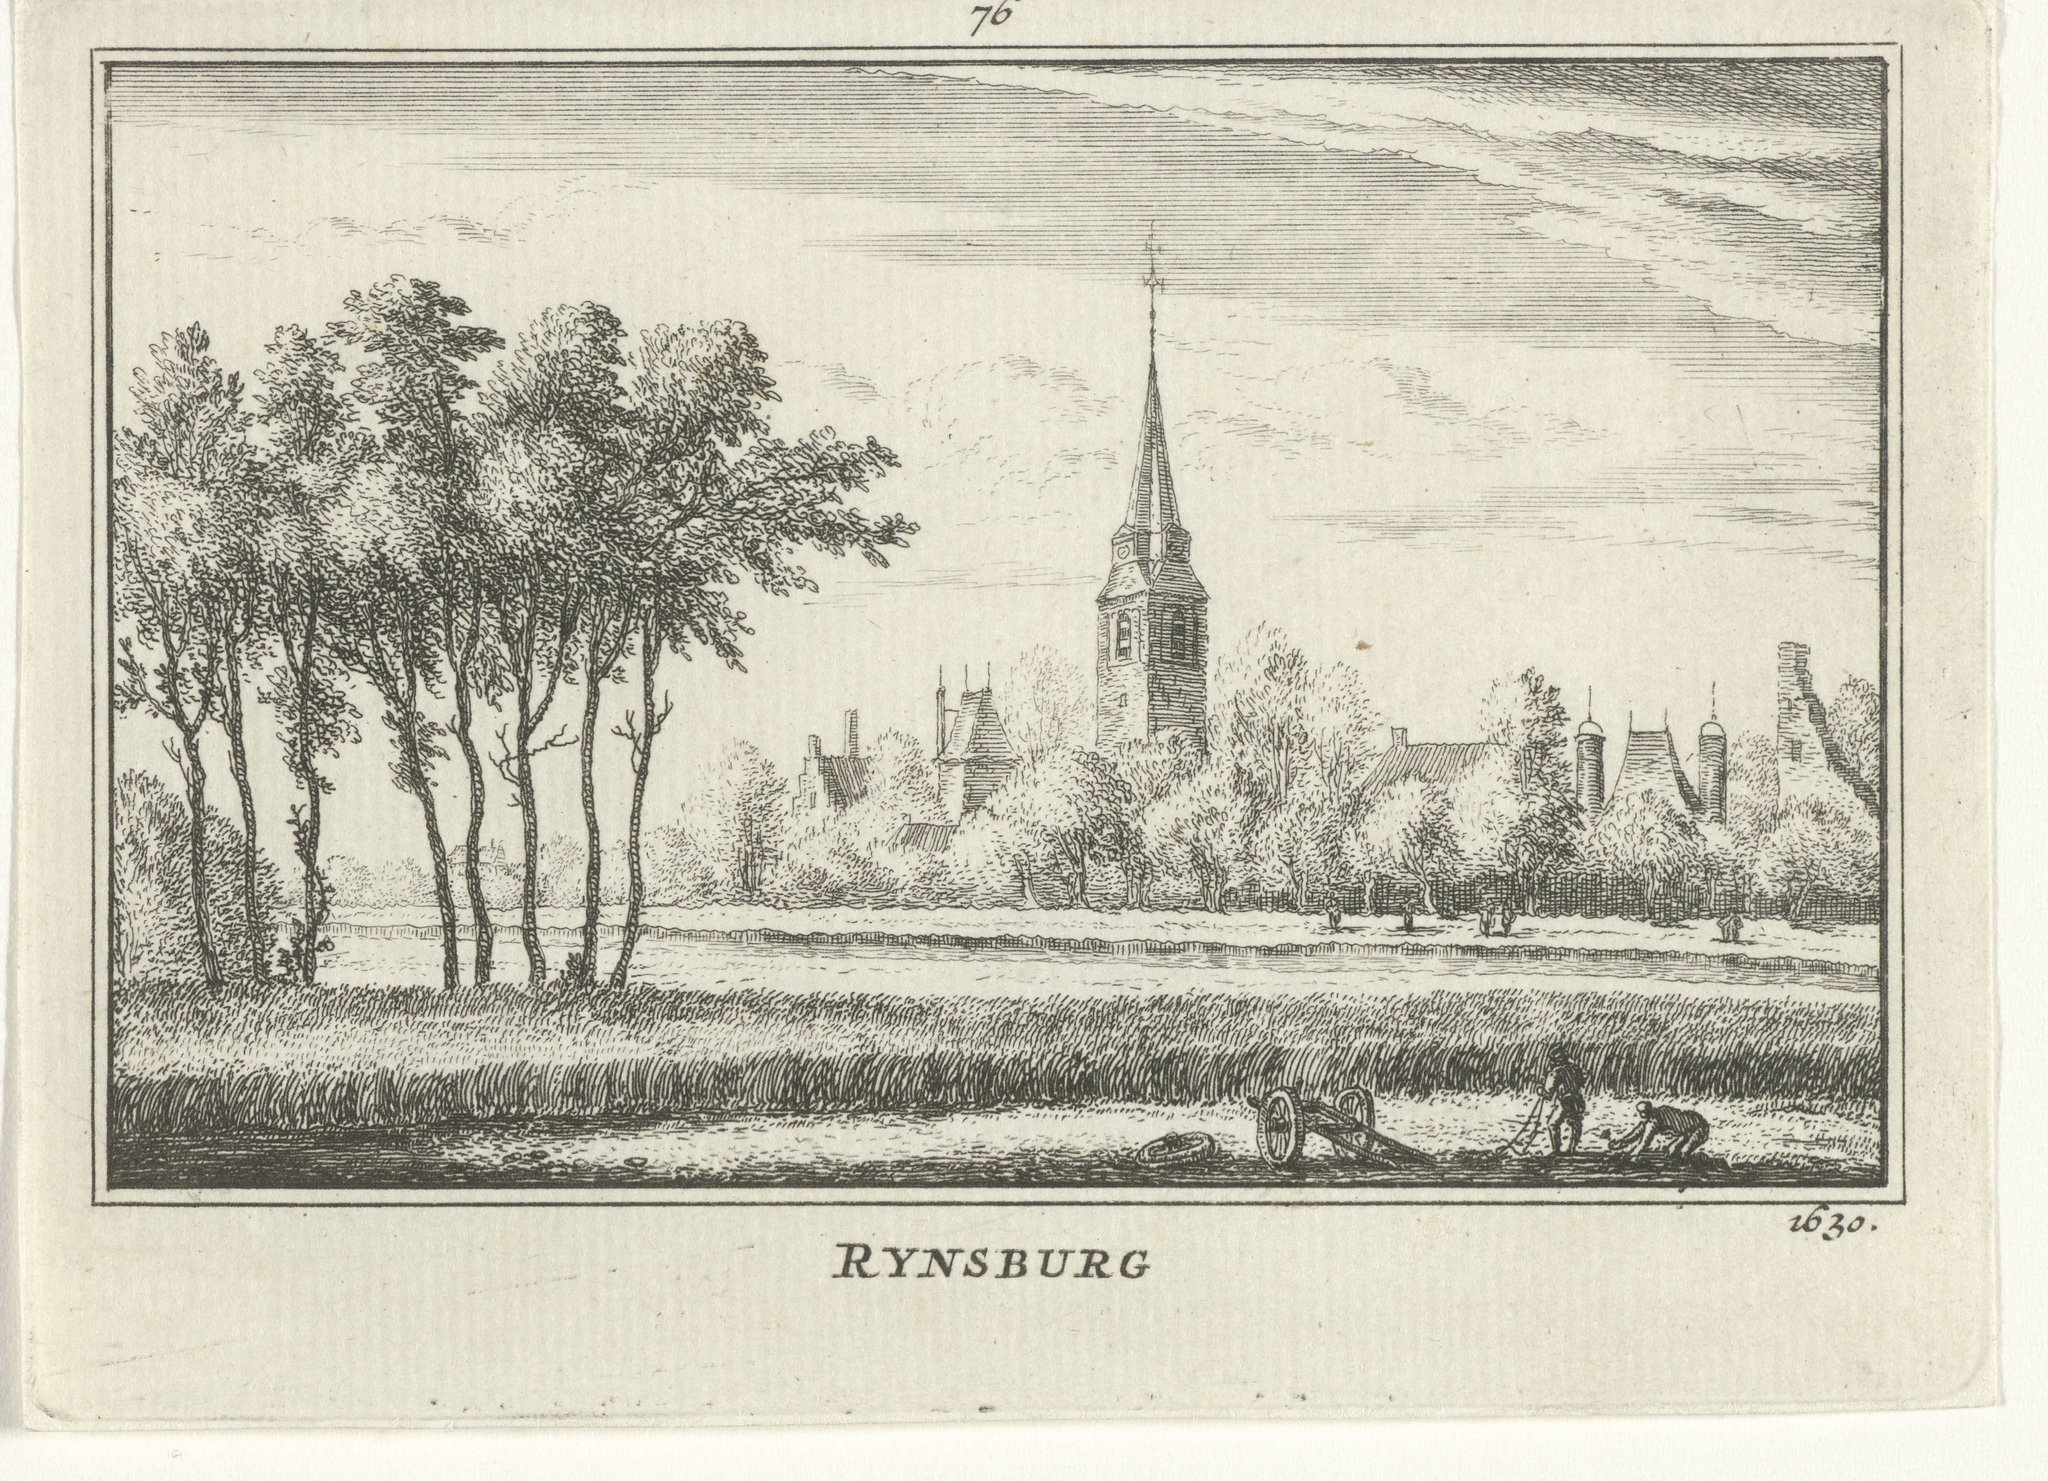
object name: book illustration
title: Gezicht op Rijnsburg, 1630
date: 1727-1733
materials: paper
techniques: etching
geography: amsterdam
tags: prospect of village, silhouette of village, church (exterior)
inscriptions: collector's mark: Lugt 2228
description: Illustratie uit: Abraham Rademaker, Matthaeus Brouërius van Niedek, Isaac Le Long, Kabinet van Nederlandsche en Kleefsche outheden en (...) voorname stads- en landgebouwen, Willem Barents en Antoni Schoonenburg: Amsterdam, 1727-1733, ill. nr. 76.